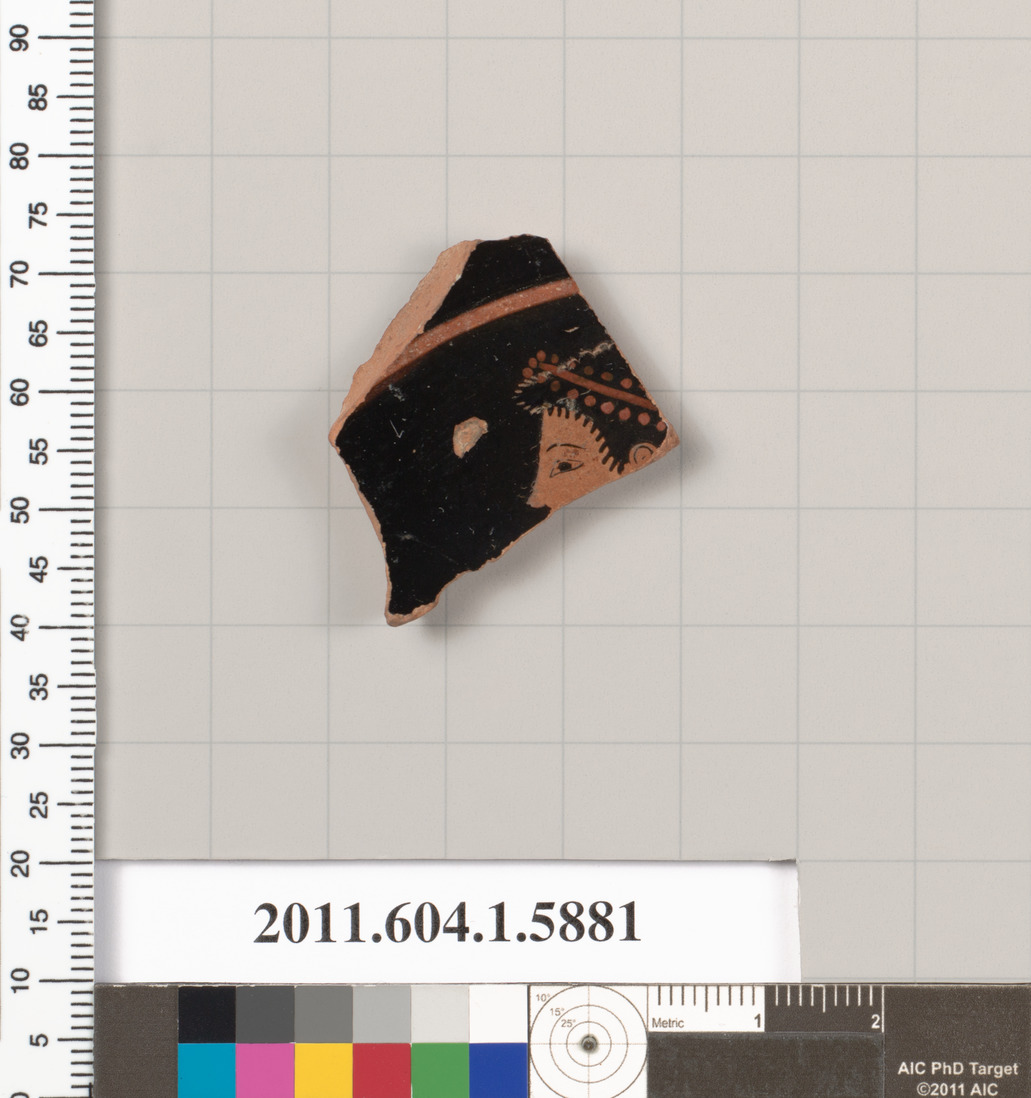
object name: kylix fragment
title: Terracotta fragment of a kylix (drinking cup)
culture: greek, attic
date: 520-510 BCE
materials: terracotta